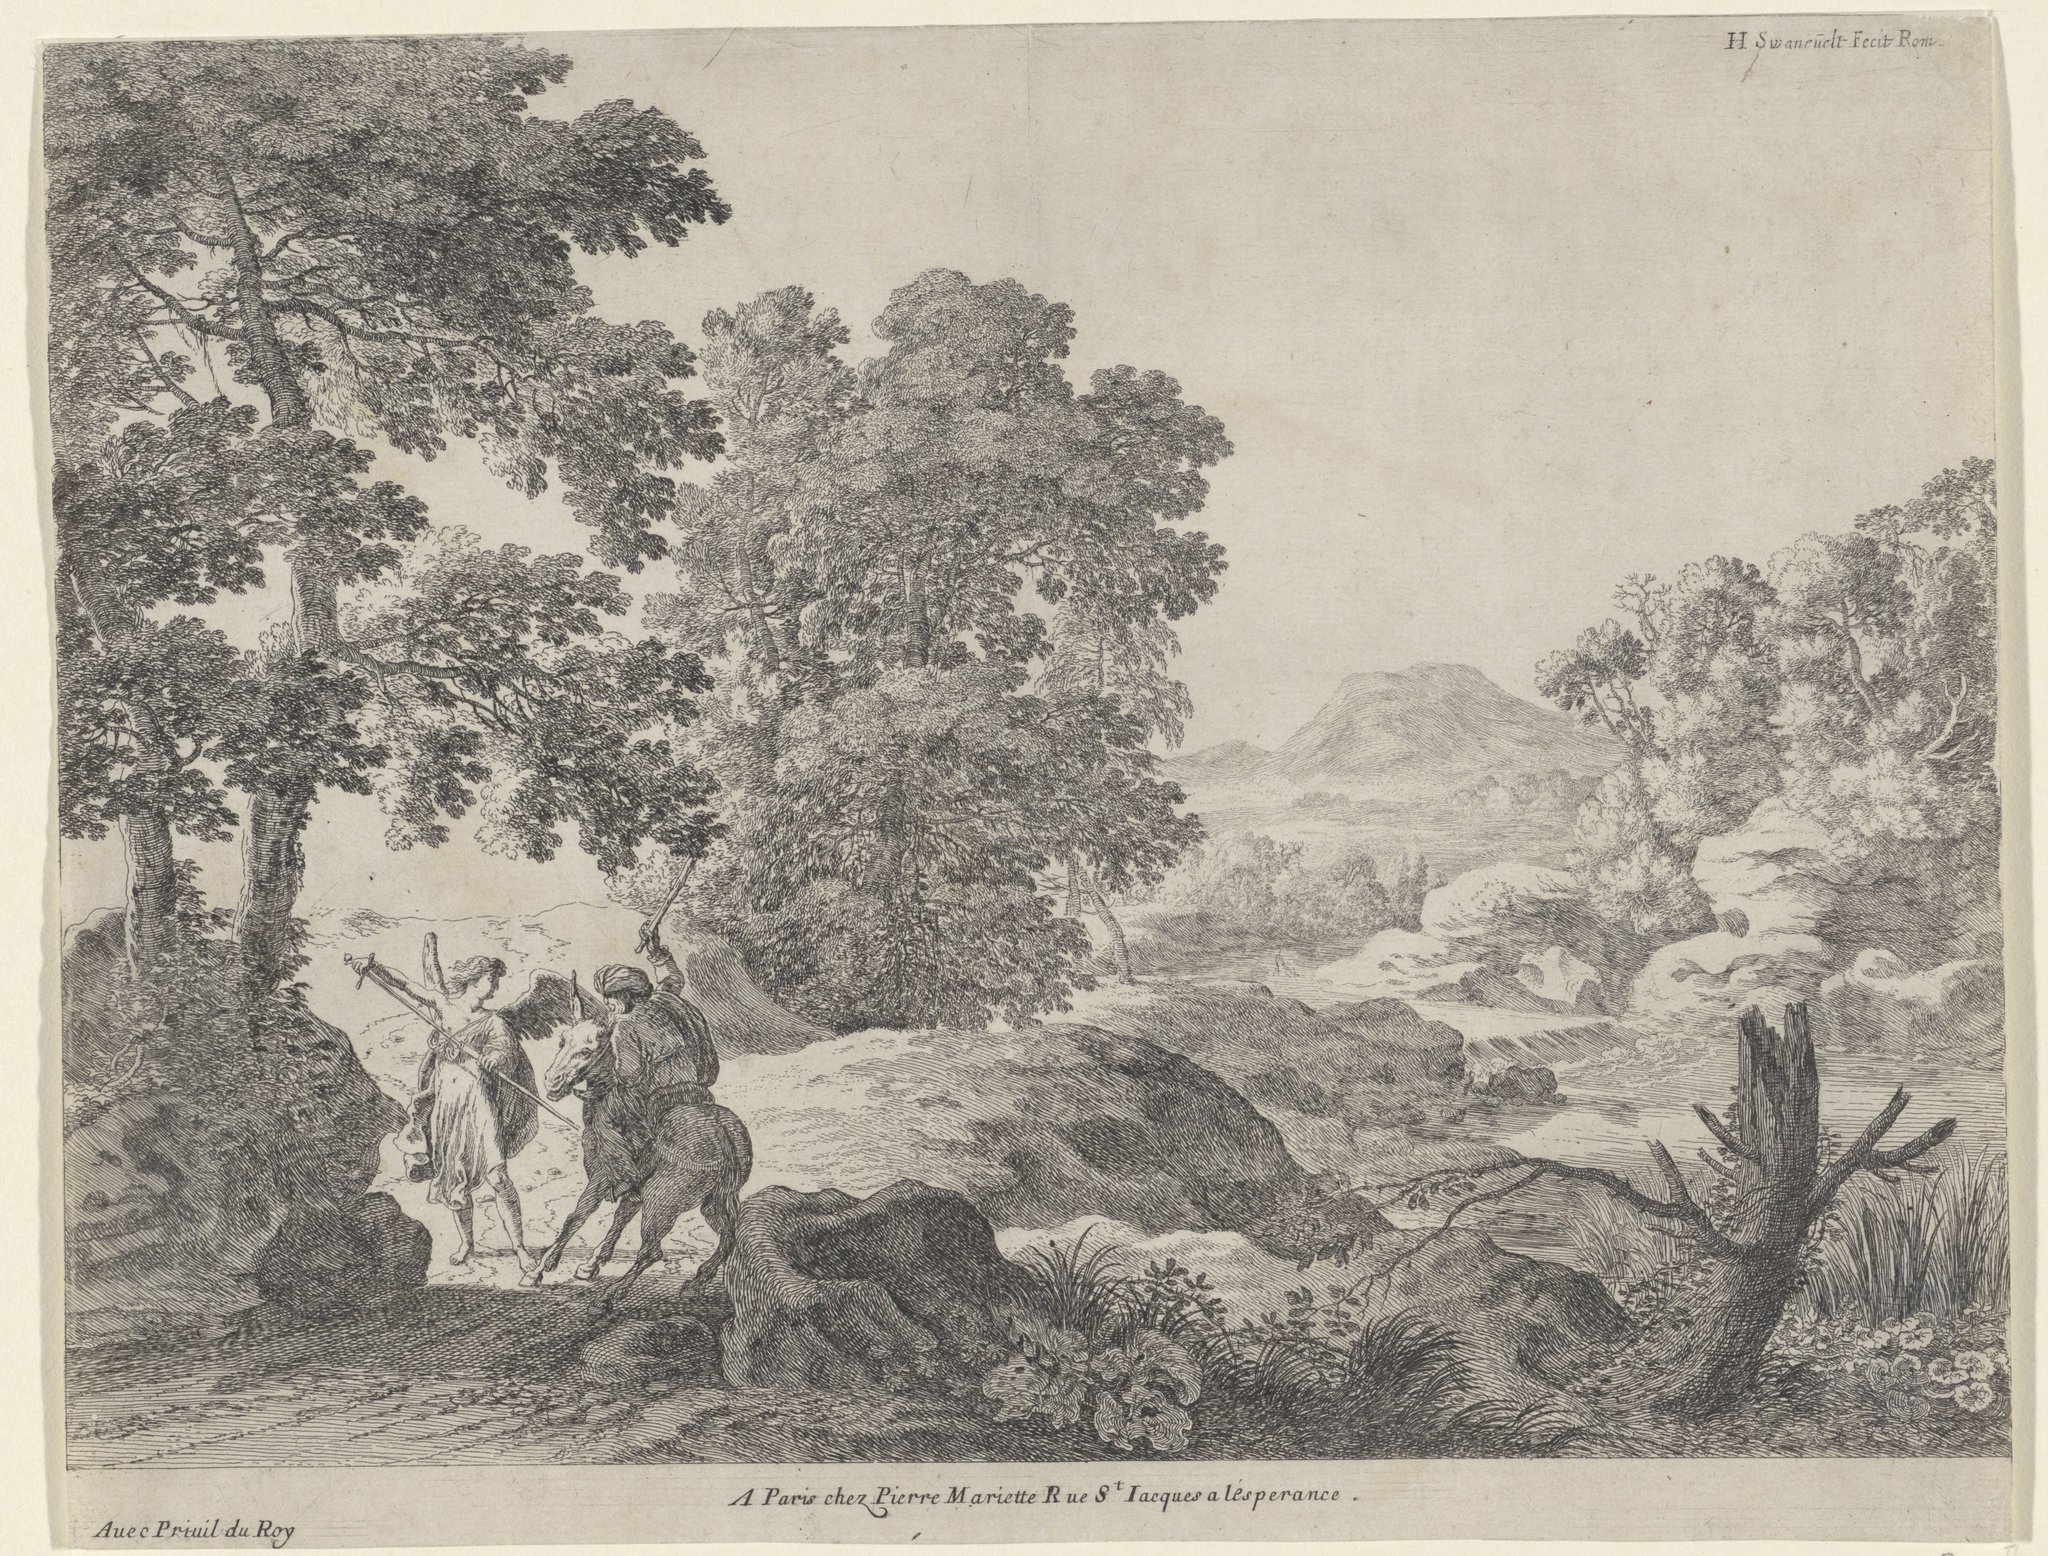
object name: print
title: Oudtestamentische voorstellingen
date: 1629-1641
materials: paper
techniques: etching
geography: paris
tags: an angel holding a sword bars the way and causes balaam's ass to turn aside; the angel is invisible to balaam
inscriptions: collector's mark: ‘KONING: BIBLIO:’ Lugt 240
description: In een heuvelachtig landschap met boompartijen is links op de voorgrond Bileam zittend op een terugdeinzende ezel weergegeven. In zijn rechterhand houdt hij een zwaard en voor hem staat een engel die een zwaard uit de schede trekt.